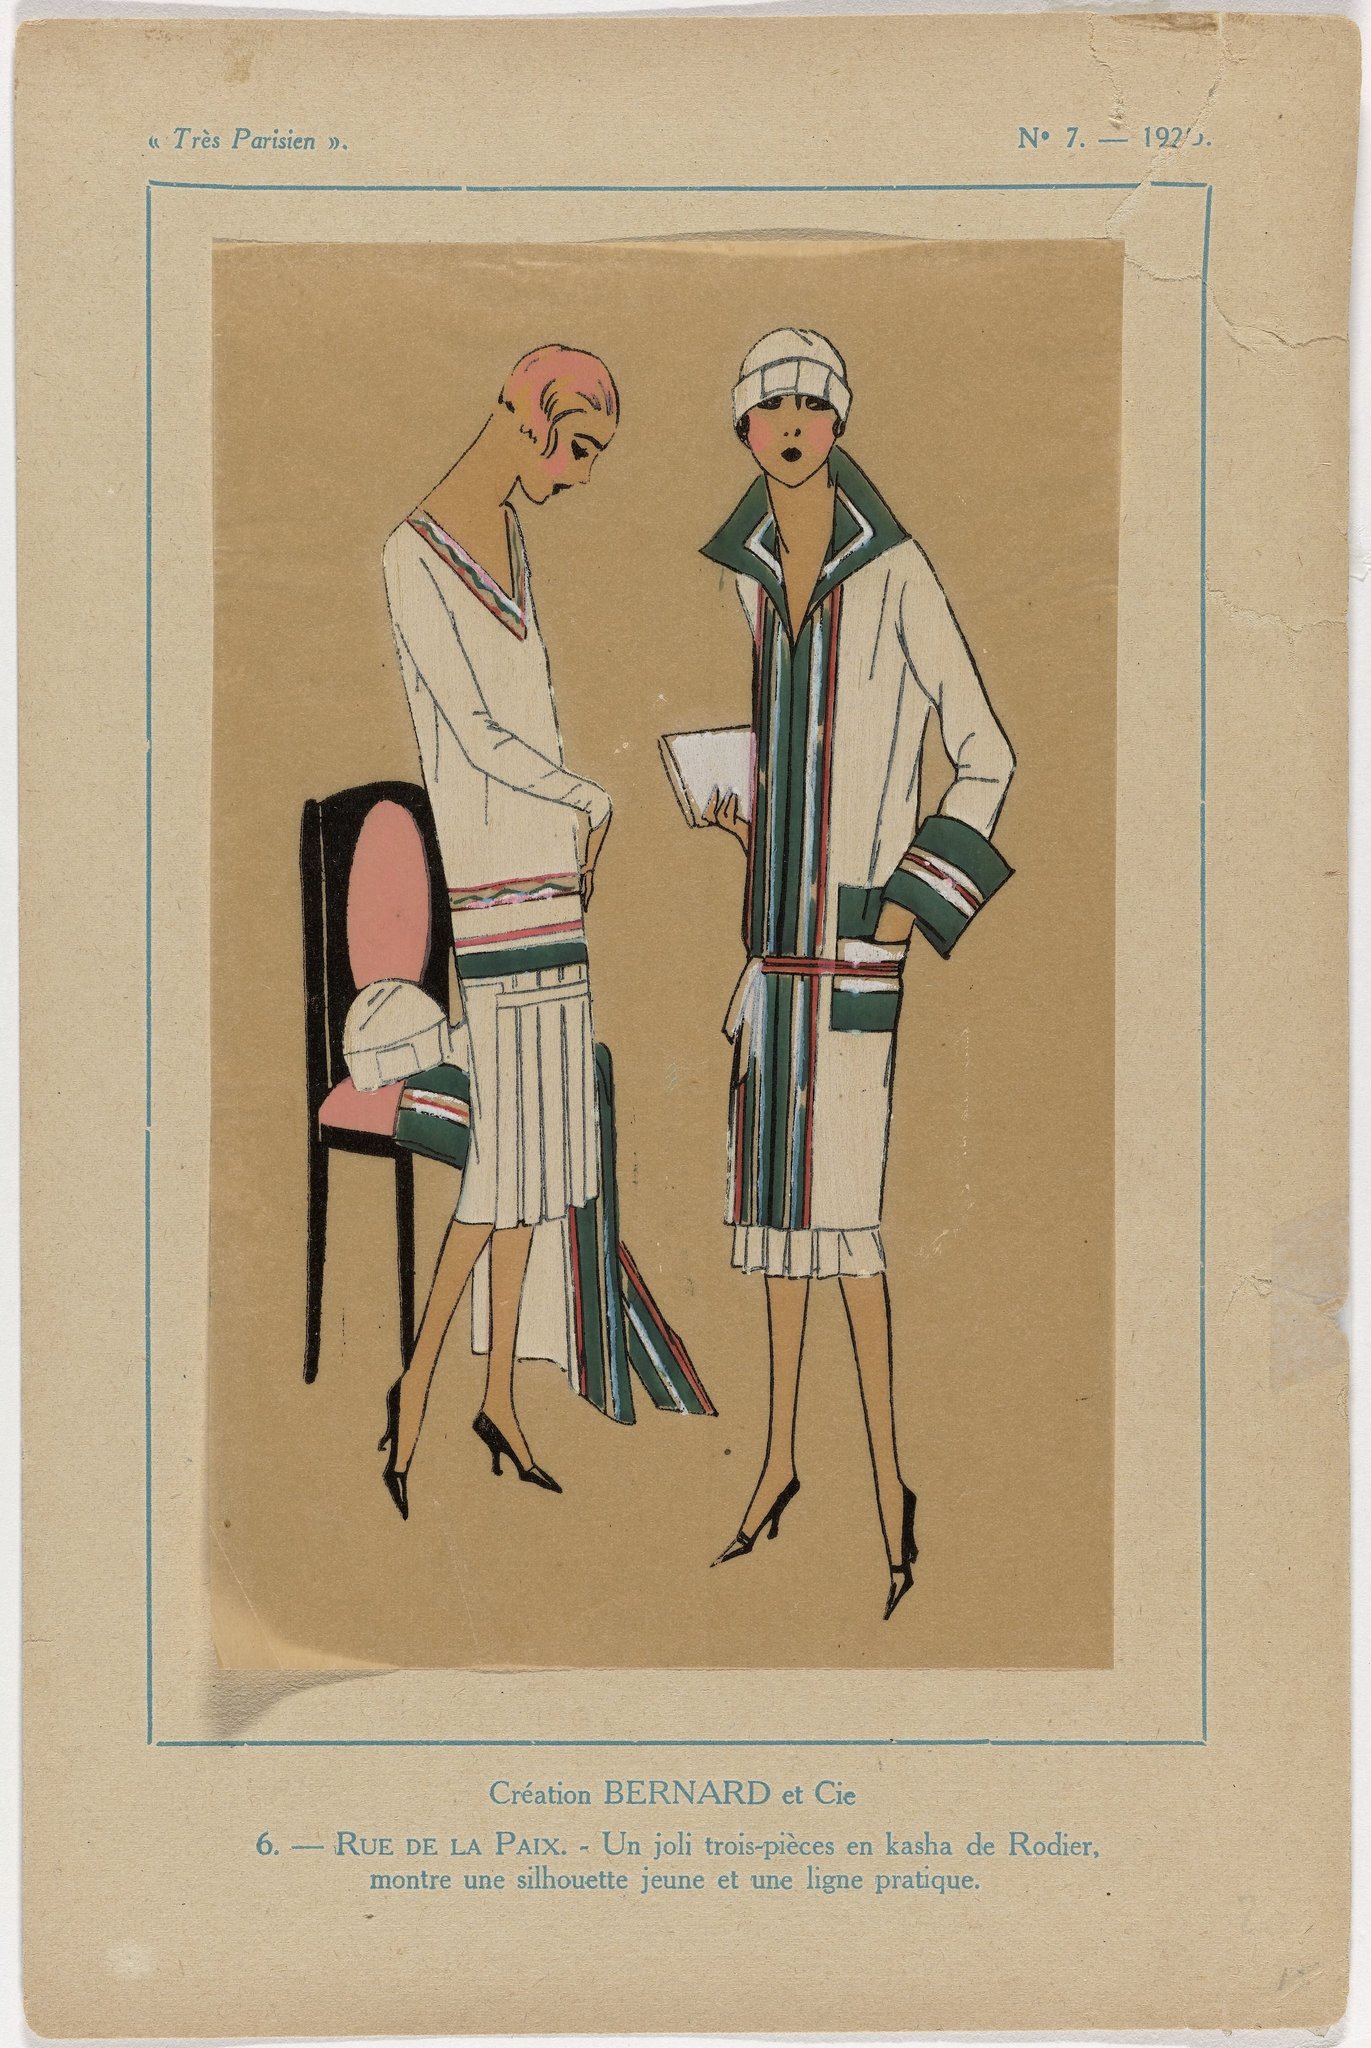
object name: fashion print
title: Très Parisien, 1925, No. 7 : Création BERNARD et Ci (...)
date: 1925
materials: paper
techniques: hand coloring, letterpress printing, lithography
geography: paris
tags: bag (handbag) (+ women's clothes), ensembles of pieces of clothing (three piece suit) (+ women's clothes), coat (+ women's clothes), head-gear (+ women's clothes), fashion plates, dress, gown (+ women's clothes)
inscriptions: caption: ‘Création BERNARD et Cie / 6. - Rue de la Paix. -Un joli trois-pièces en kasha de Rodier, montre une silhouette jeune et une ligne pratique.’, title: ‘"Très Parisien" / No 7. - 1925’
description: Ontwerp van Bernard et Cie. Trois-pièces (mantelpak) van 'kasha' van Rodier. Prent uit het modetijdschrift Très Parisien (1920-1936).